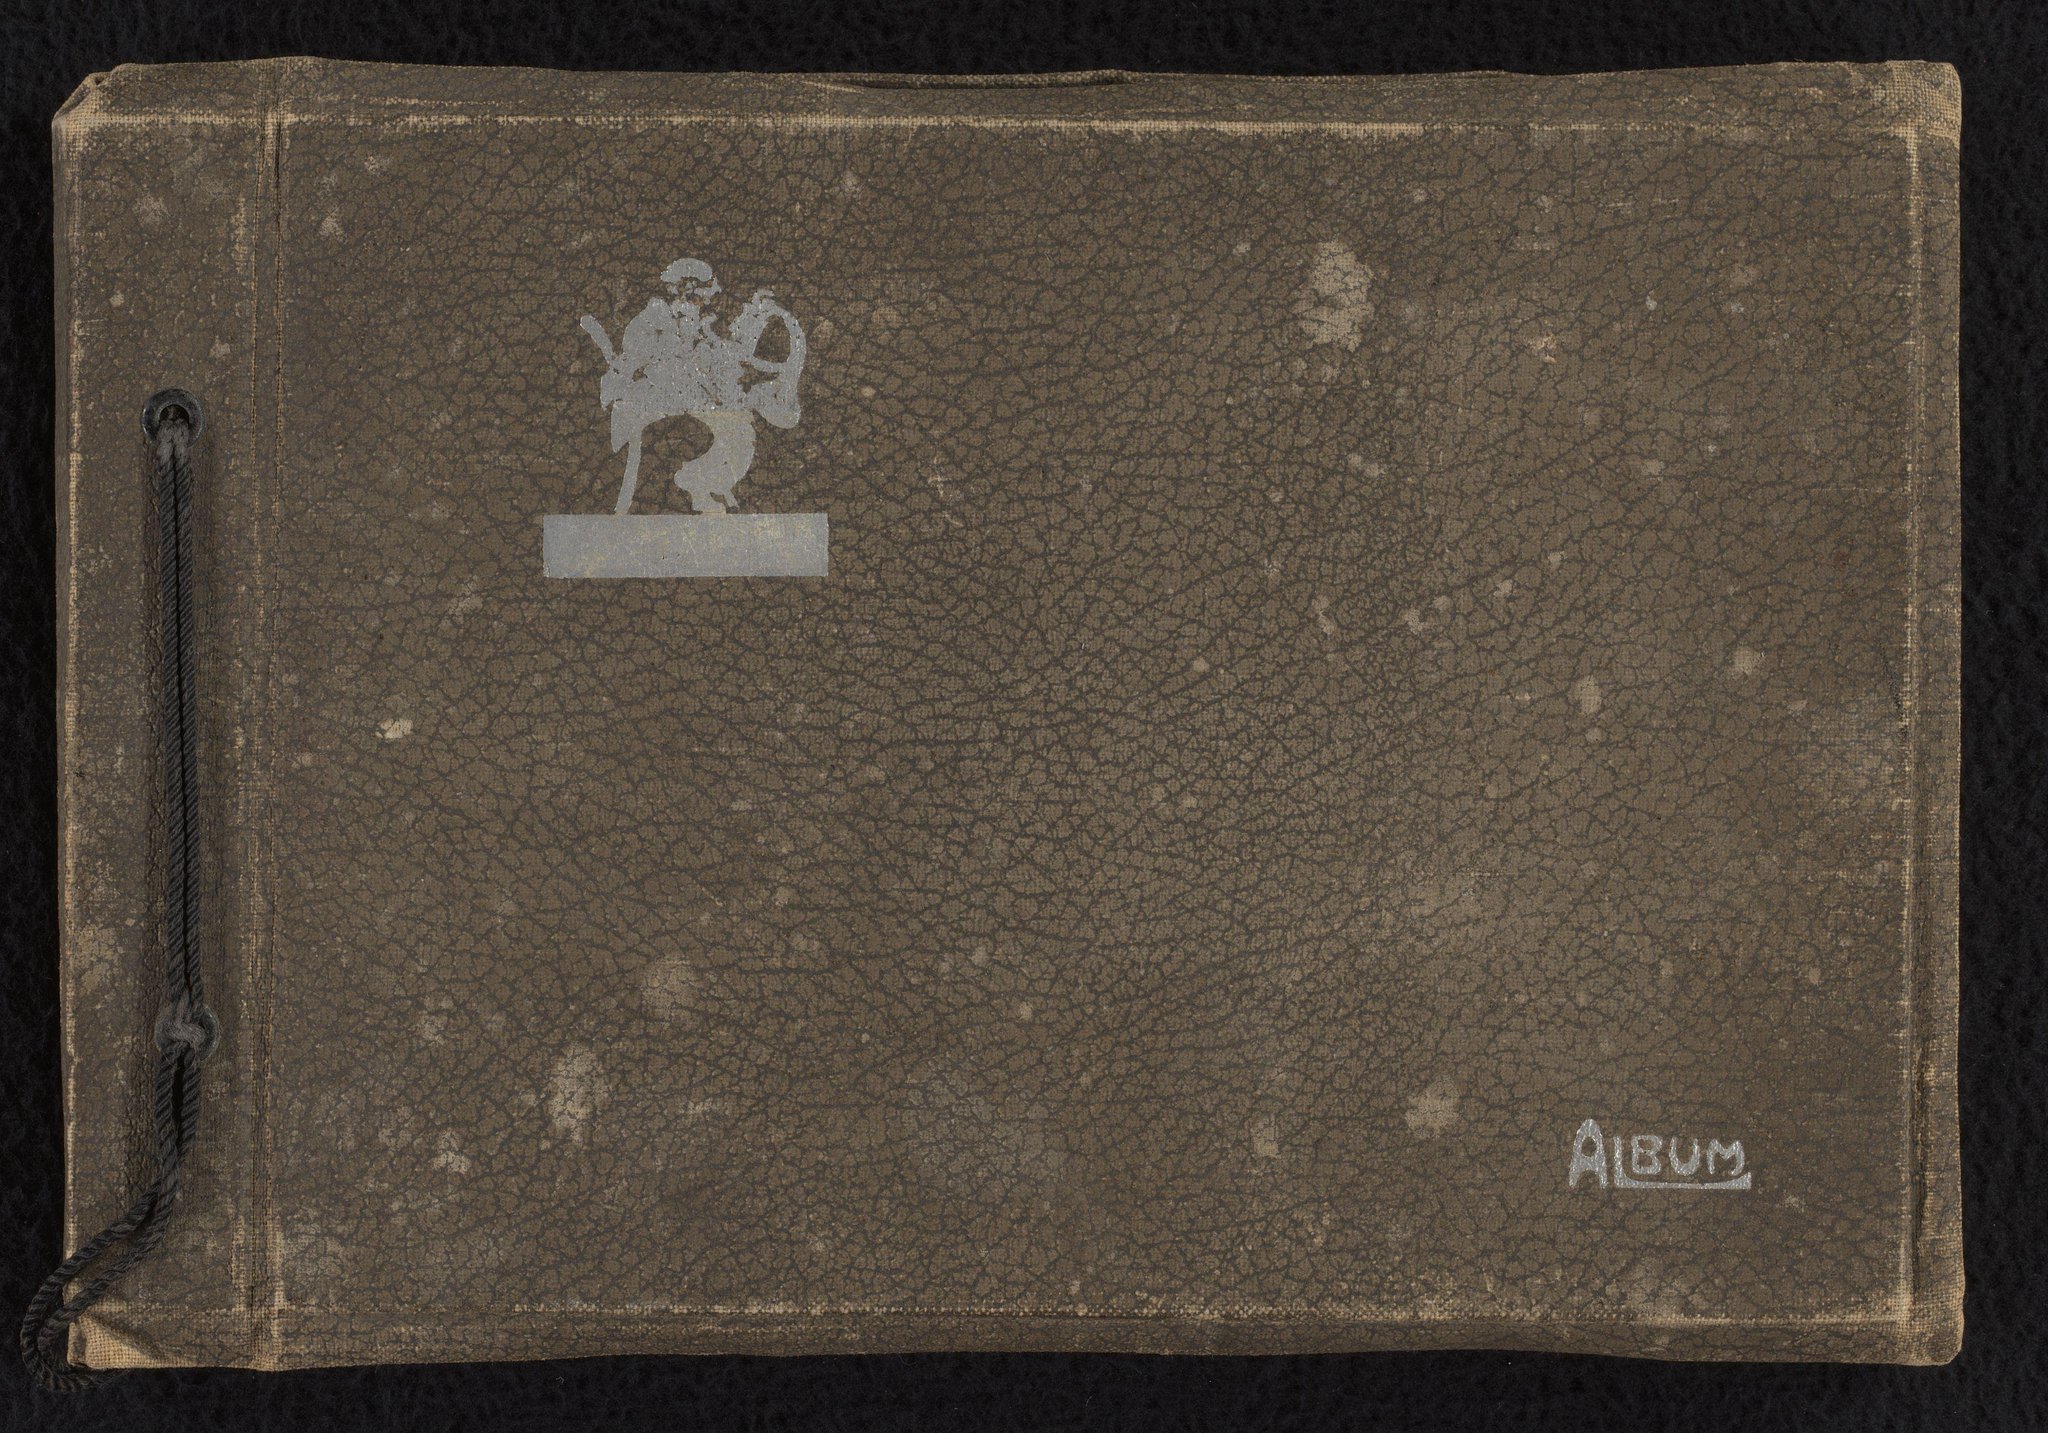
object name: photograph album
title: Fotoalbum met foto's van militairen van het Japans Keizerlijk Leger, voornamelijk soldaten van het 76e infanterie regiment die gelegerd waren in Korea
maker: Anonymous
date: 1930-1940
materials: paper, cardboard, textile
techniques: gelatin silver print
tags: the soldier; the soldier's life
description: Fotoalbum met 114 foto's van militairen van het Japans Keizerlijk Leger, voornamelijk soldaten van het 76e infanterie regiment die gelegerd waren in Korea, op 47 bladen.